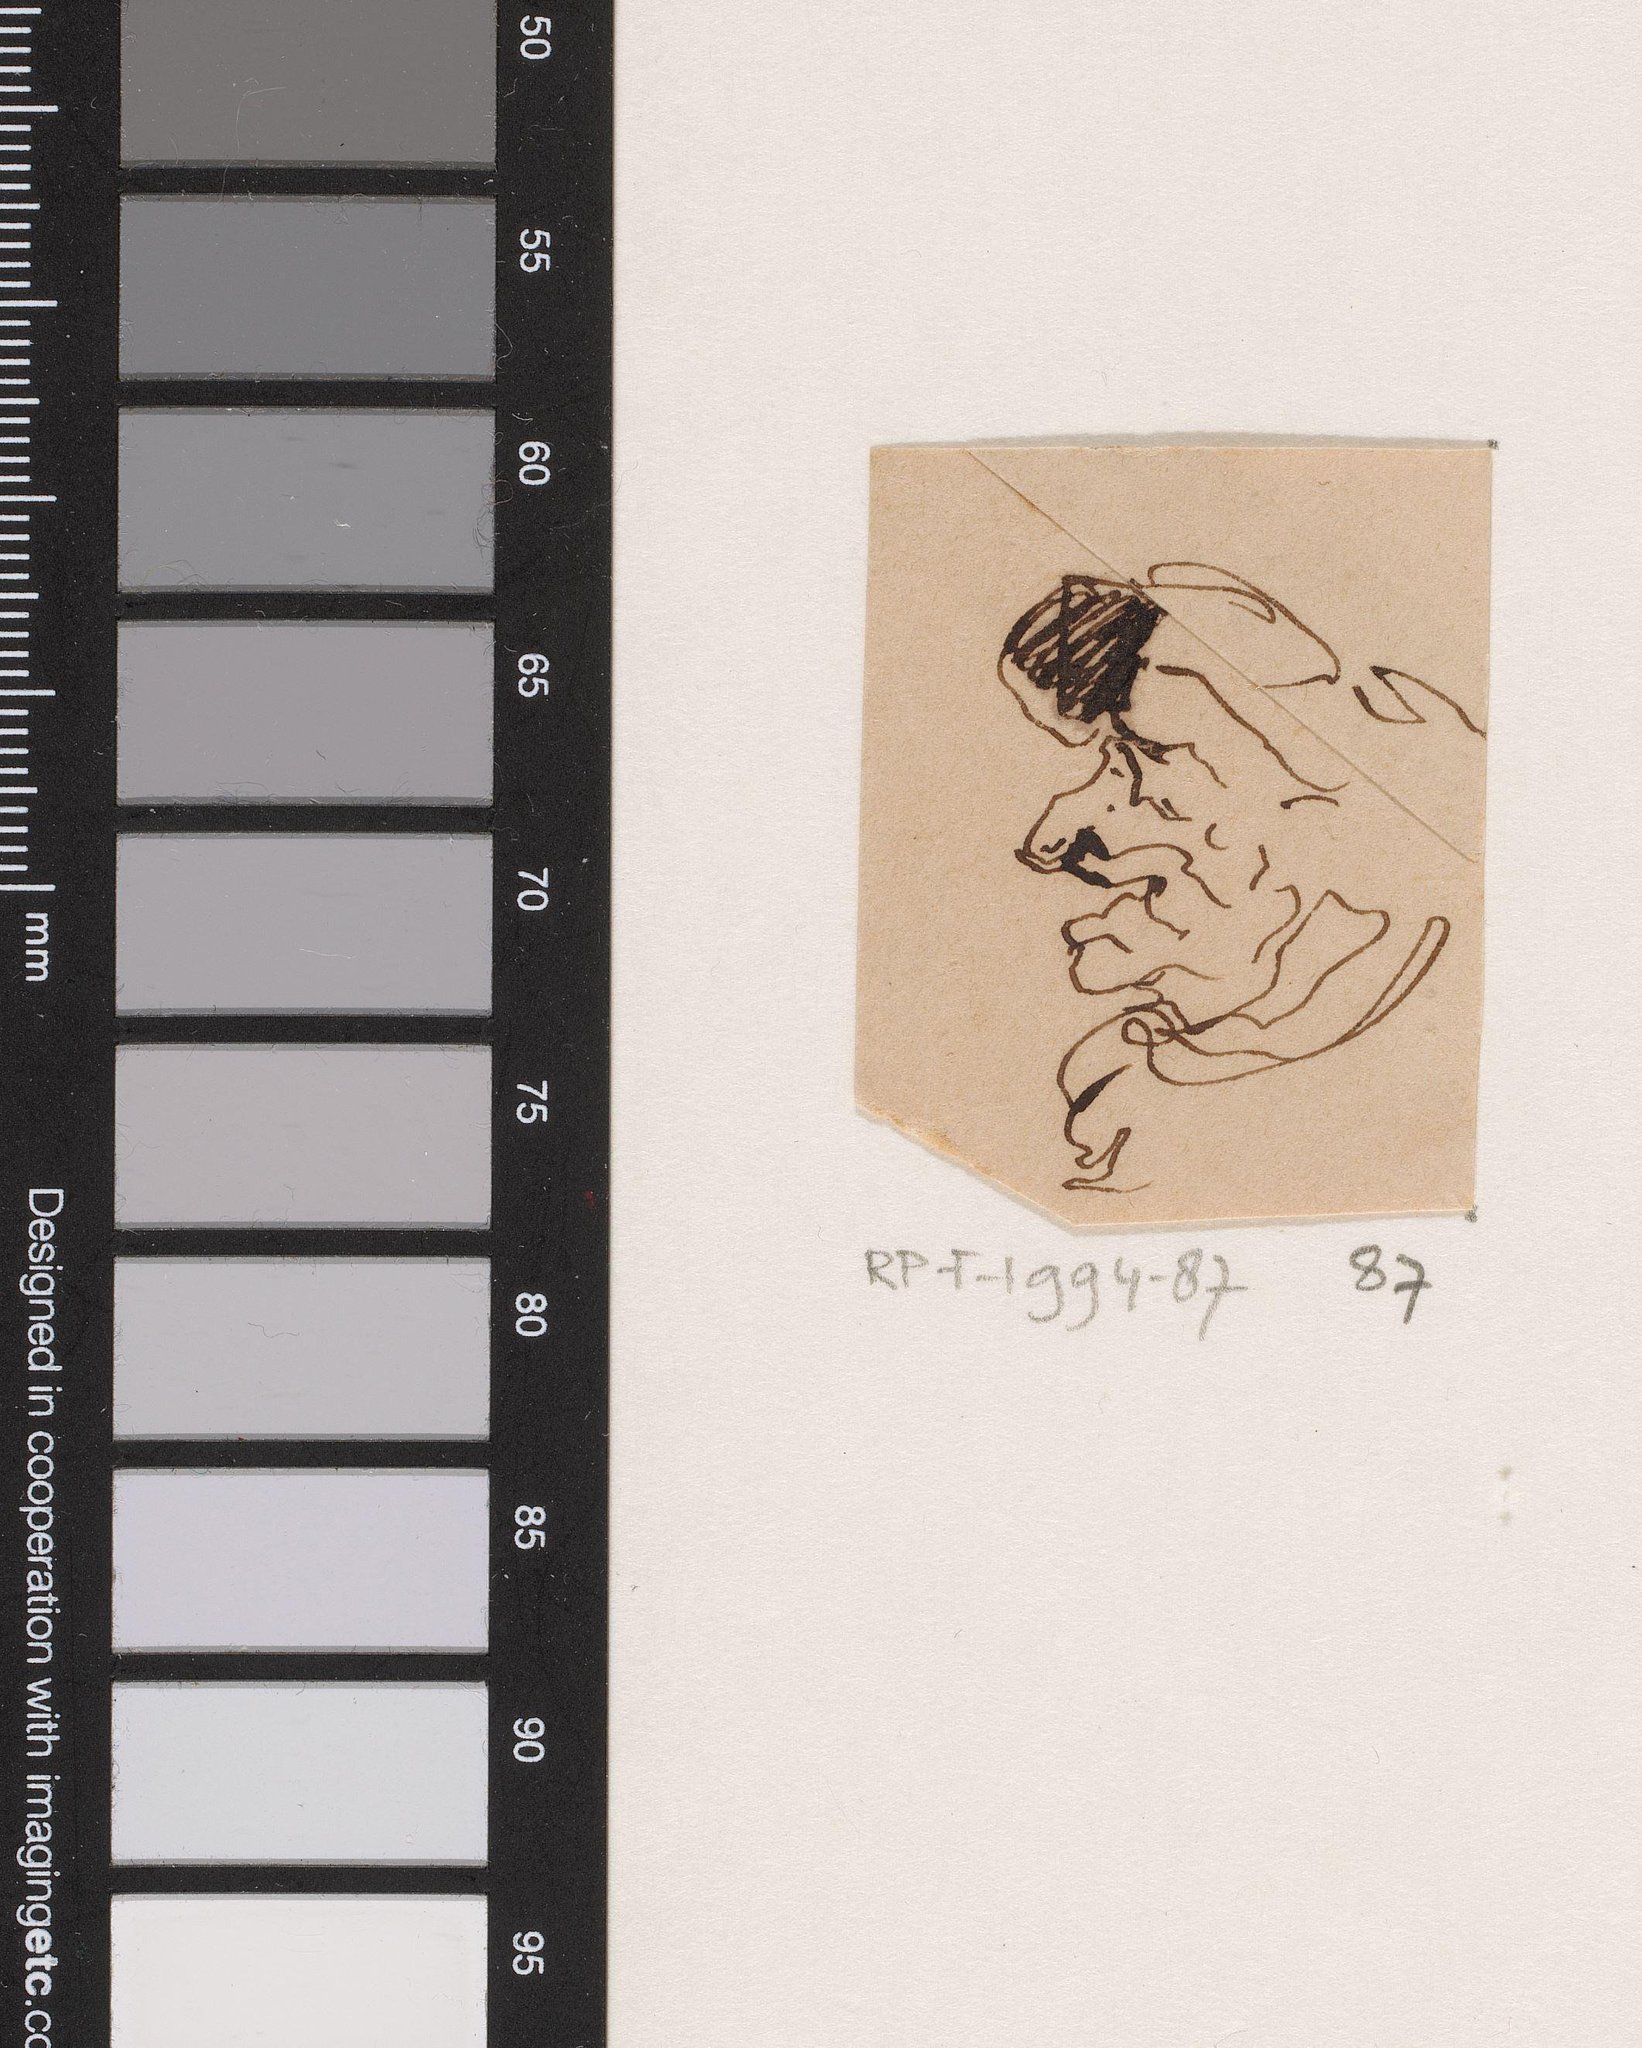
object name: drawing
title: Kop van een man, in profiel naar links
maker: johannes tavenraat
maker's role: draughtsman, painter, print maker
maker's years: 1809-1881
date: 1819-1881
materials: ink, paper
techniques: pen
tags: caricatures (human types)